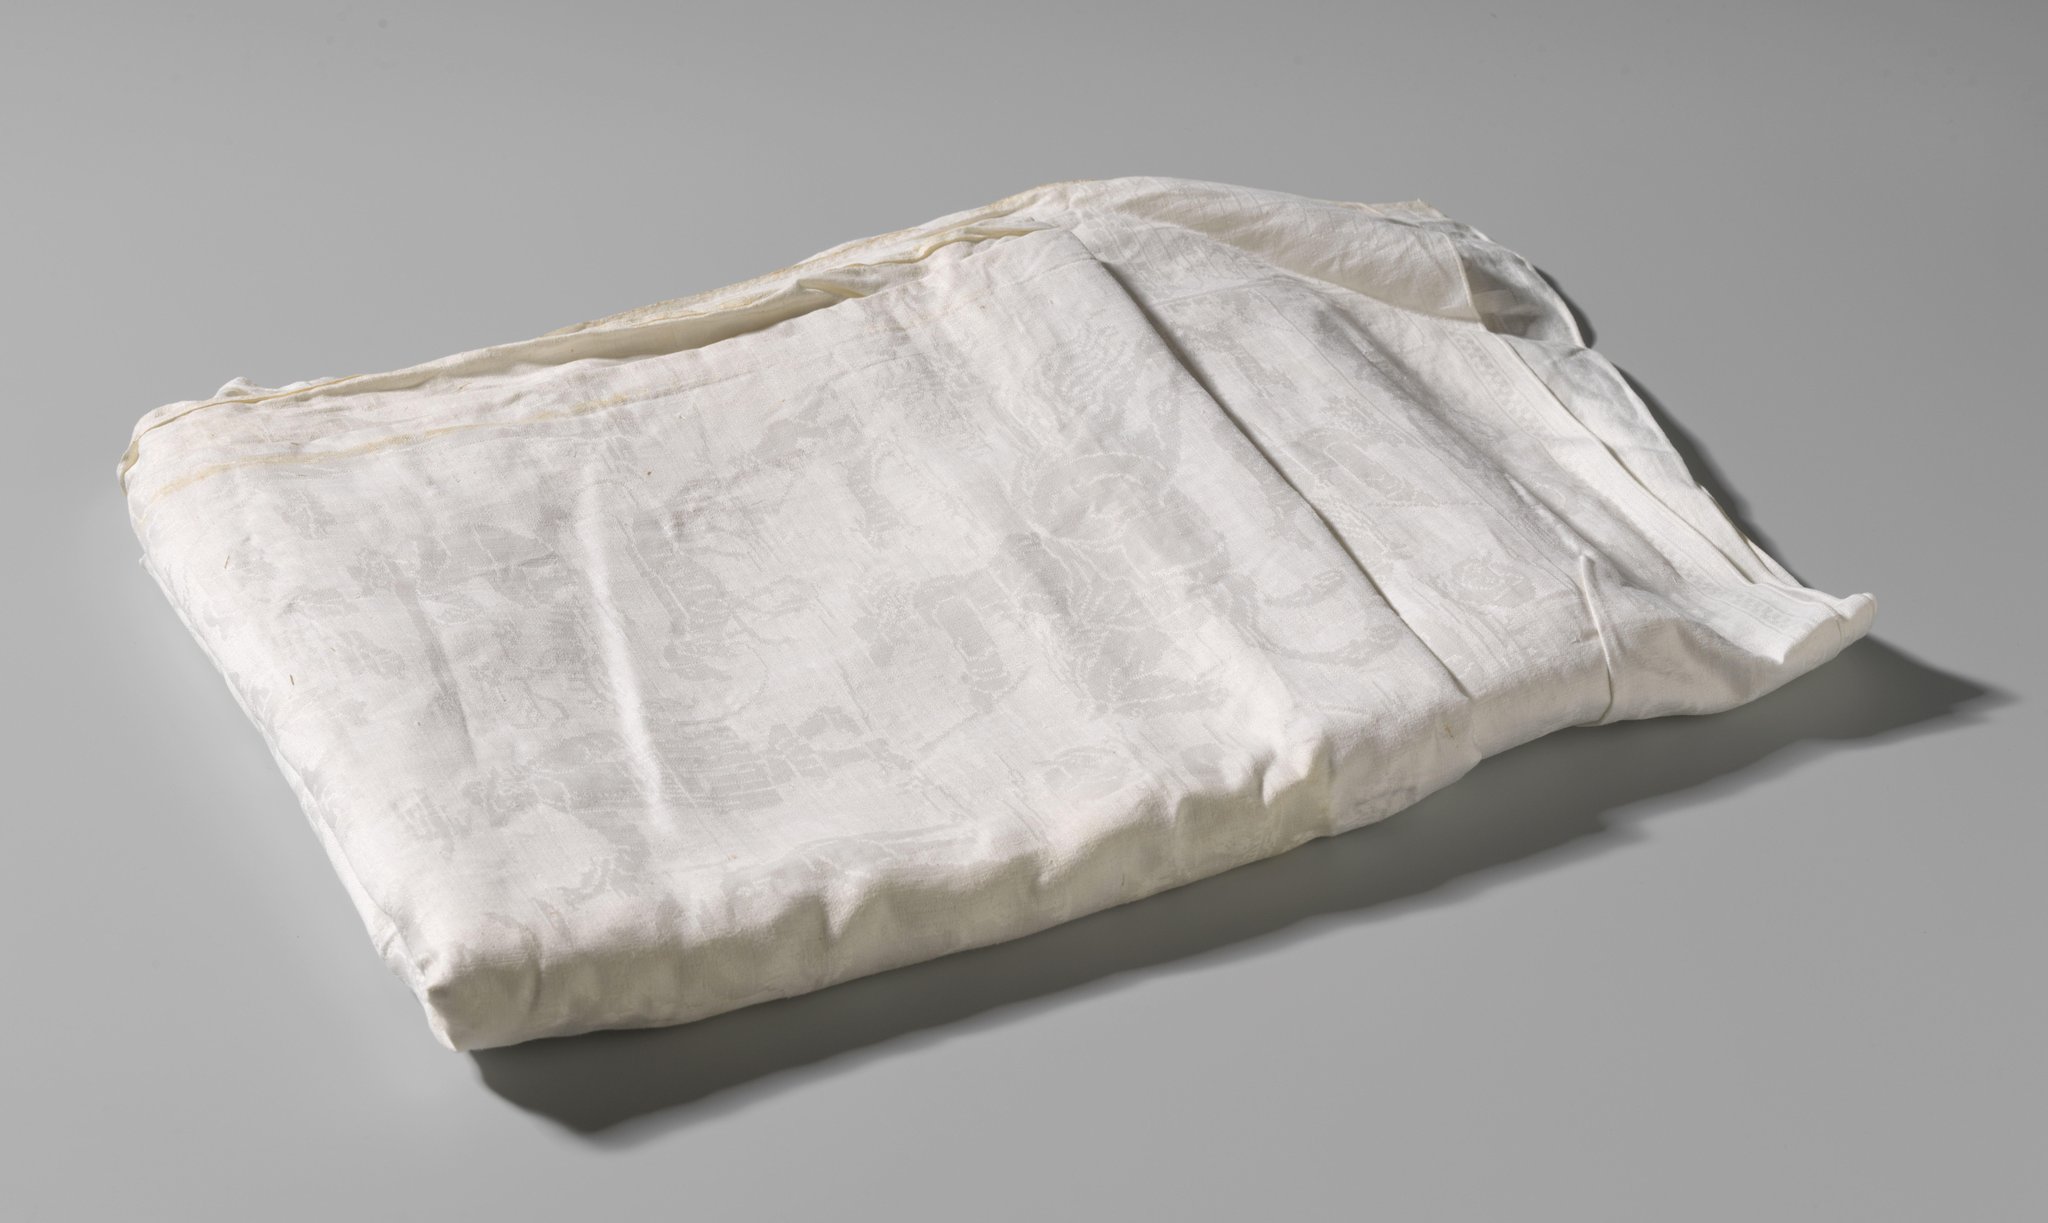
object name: tablecloth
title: Tafellaken met wapen Bartolotti van den Heuvel.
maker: Anonymous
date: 1640-1660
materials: linen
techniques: damask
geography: netherlands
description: Wit linnen damasten tafellaken met jachtmotieven en in de hoeken het wapen van Bartolotti van den Heuvel.